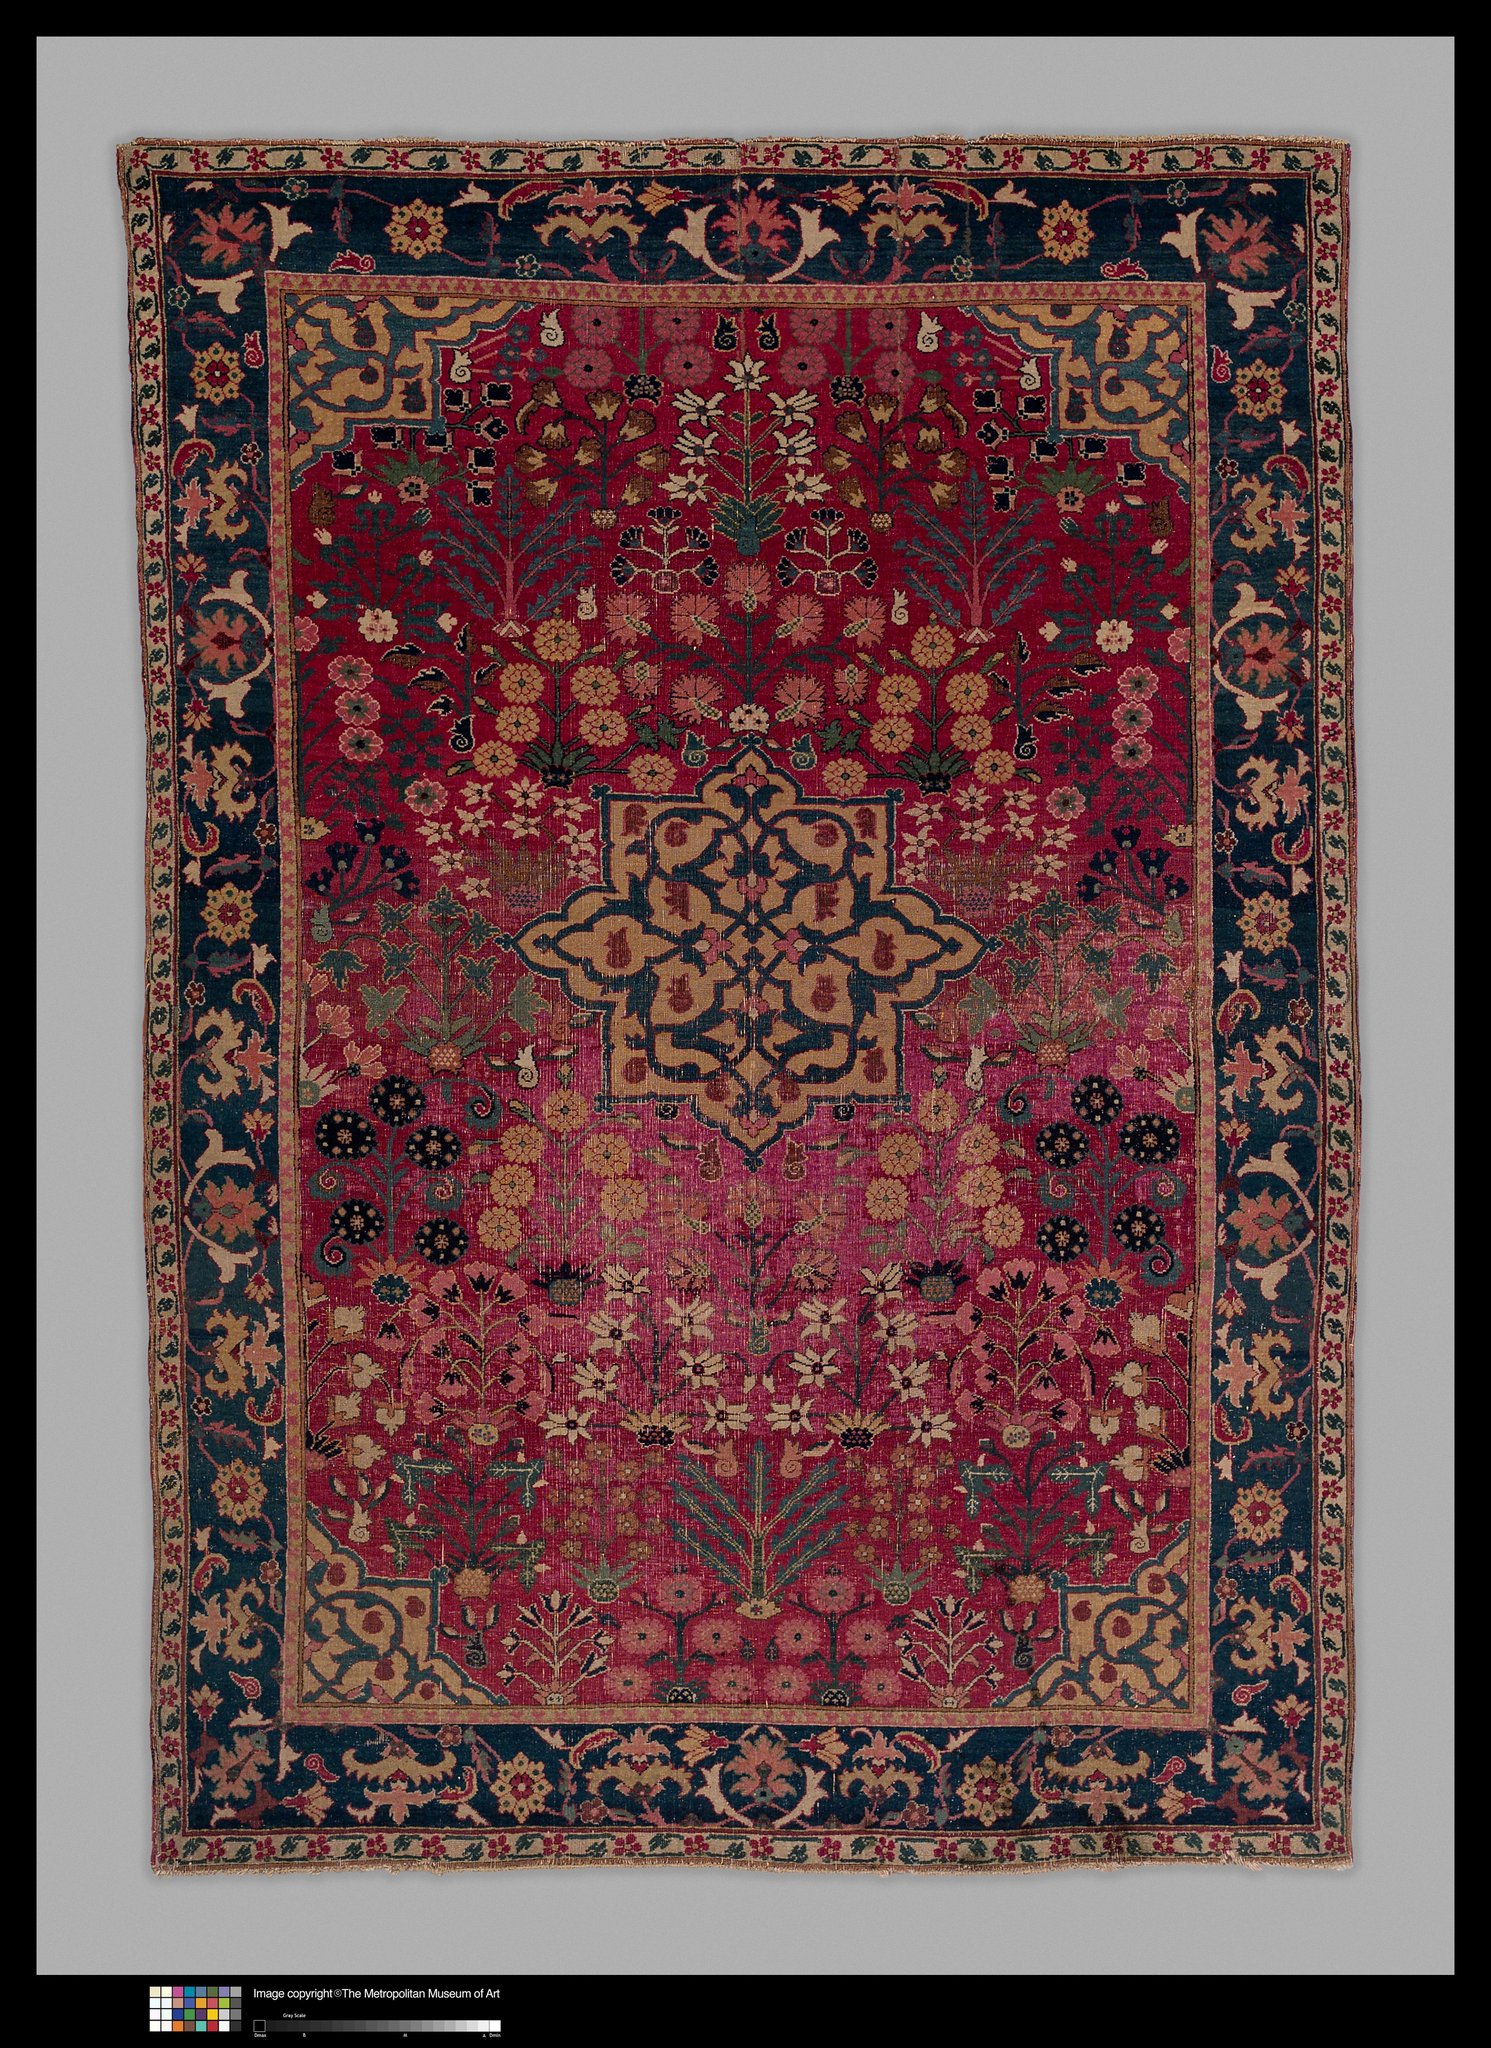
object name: carpet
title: Vase Carpet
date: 1601-1700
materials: cotton, silk, wool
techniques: asymmetrically knotted pile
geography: iran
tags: flowers